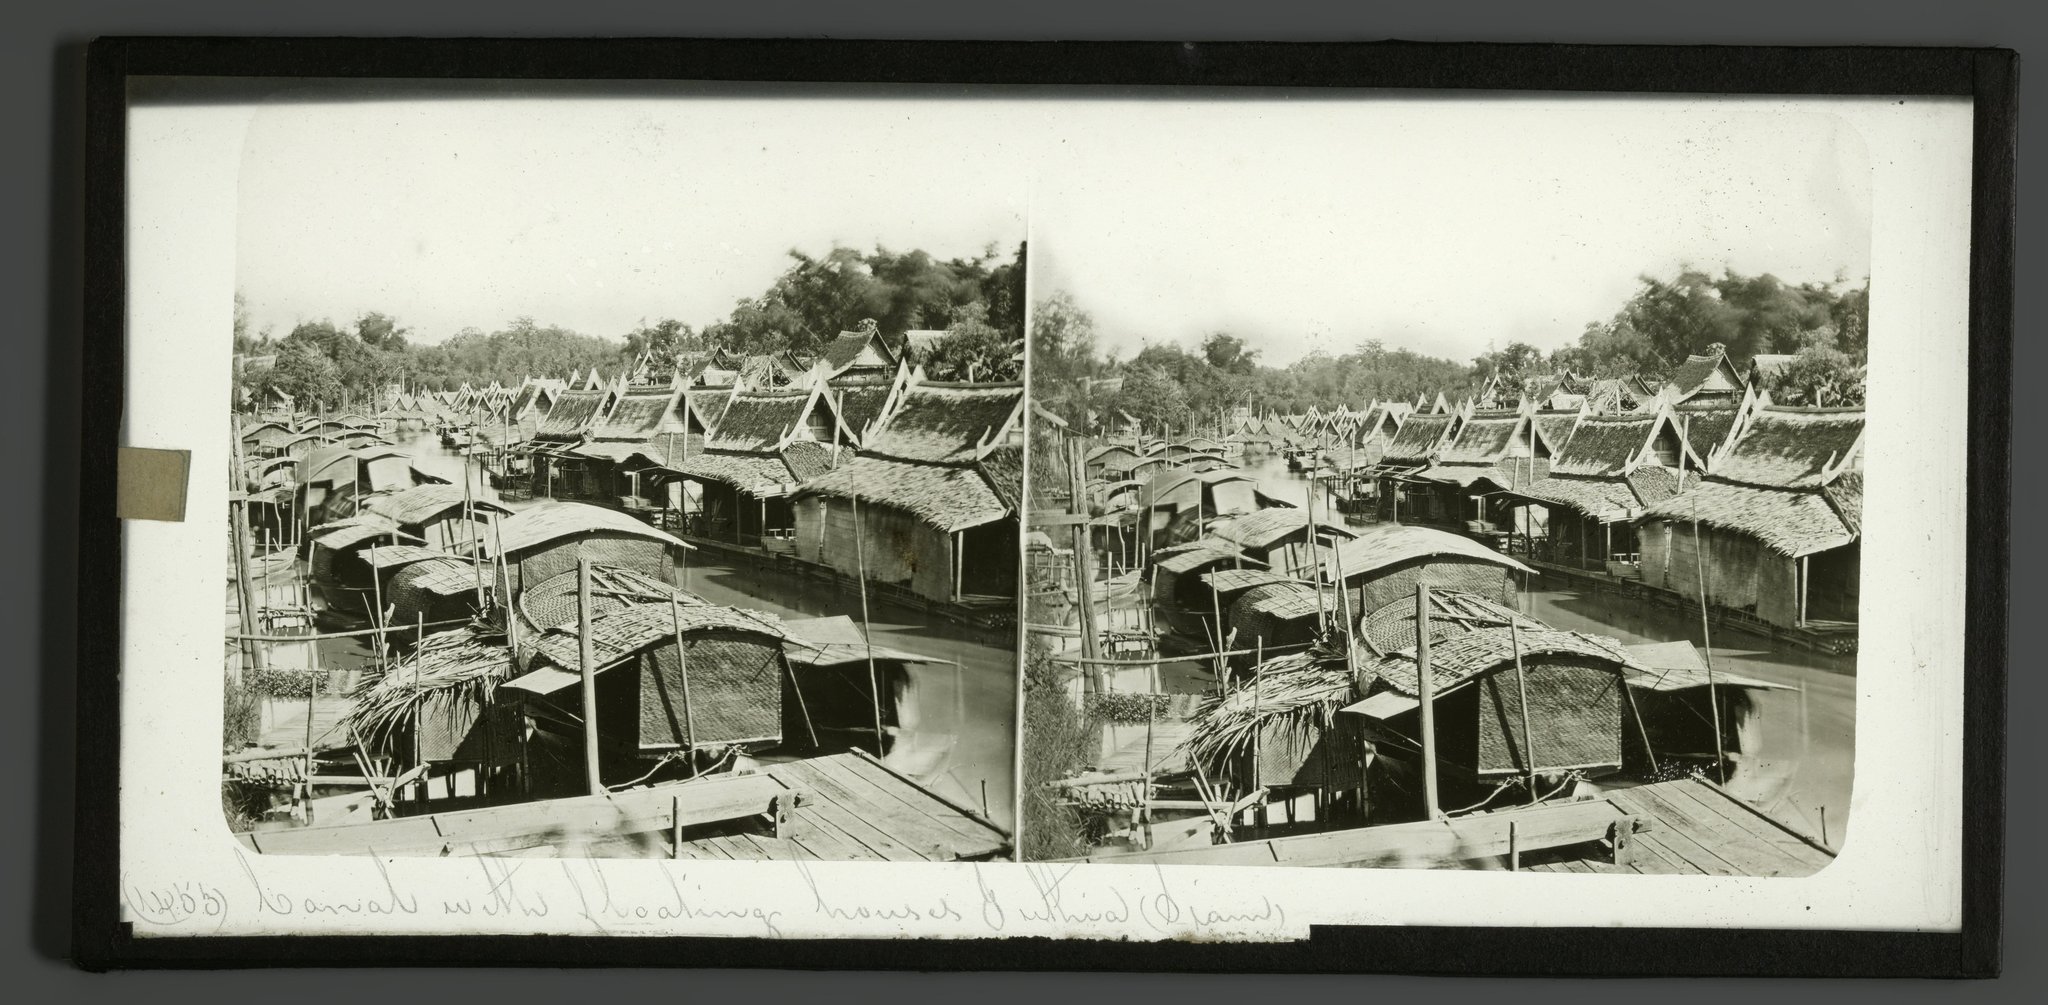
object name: photograph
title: Canal with floating houses Puthia (Siam)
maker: Anonymous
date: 1860-1890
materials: glass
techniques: slide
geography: puthia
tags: canals, waters (in village), houseboat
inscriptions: number: ‘1463’